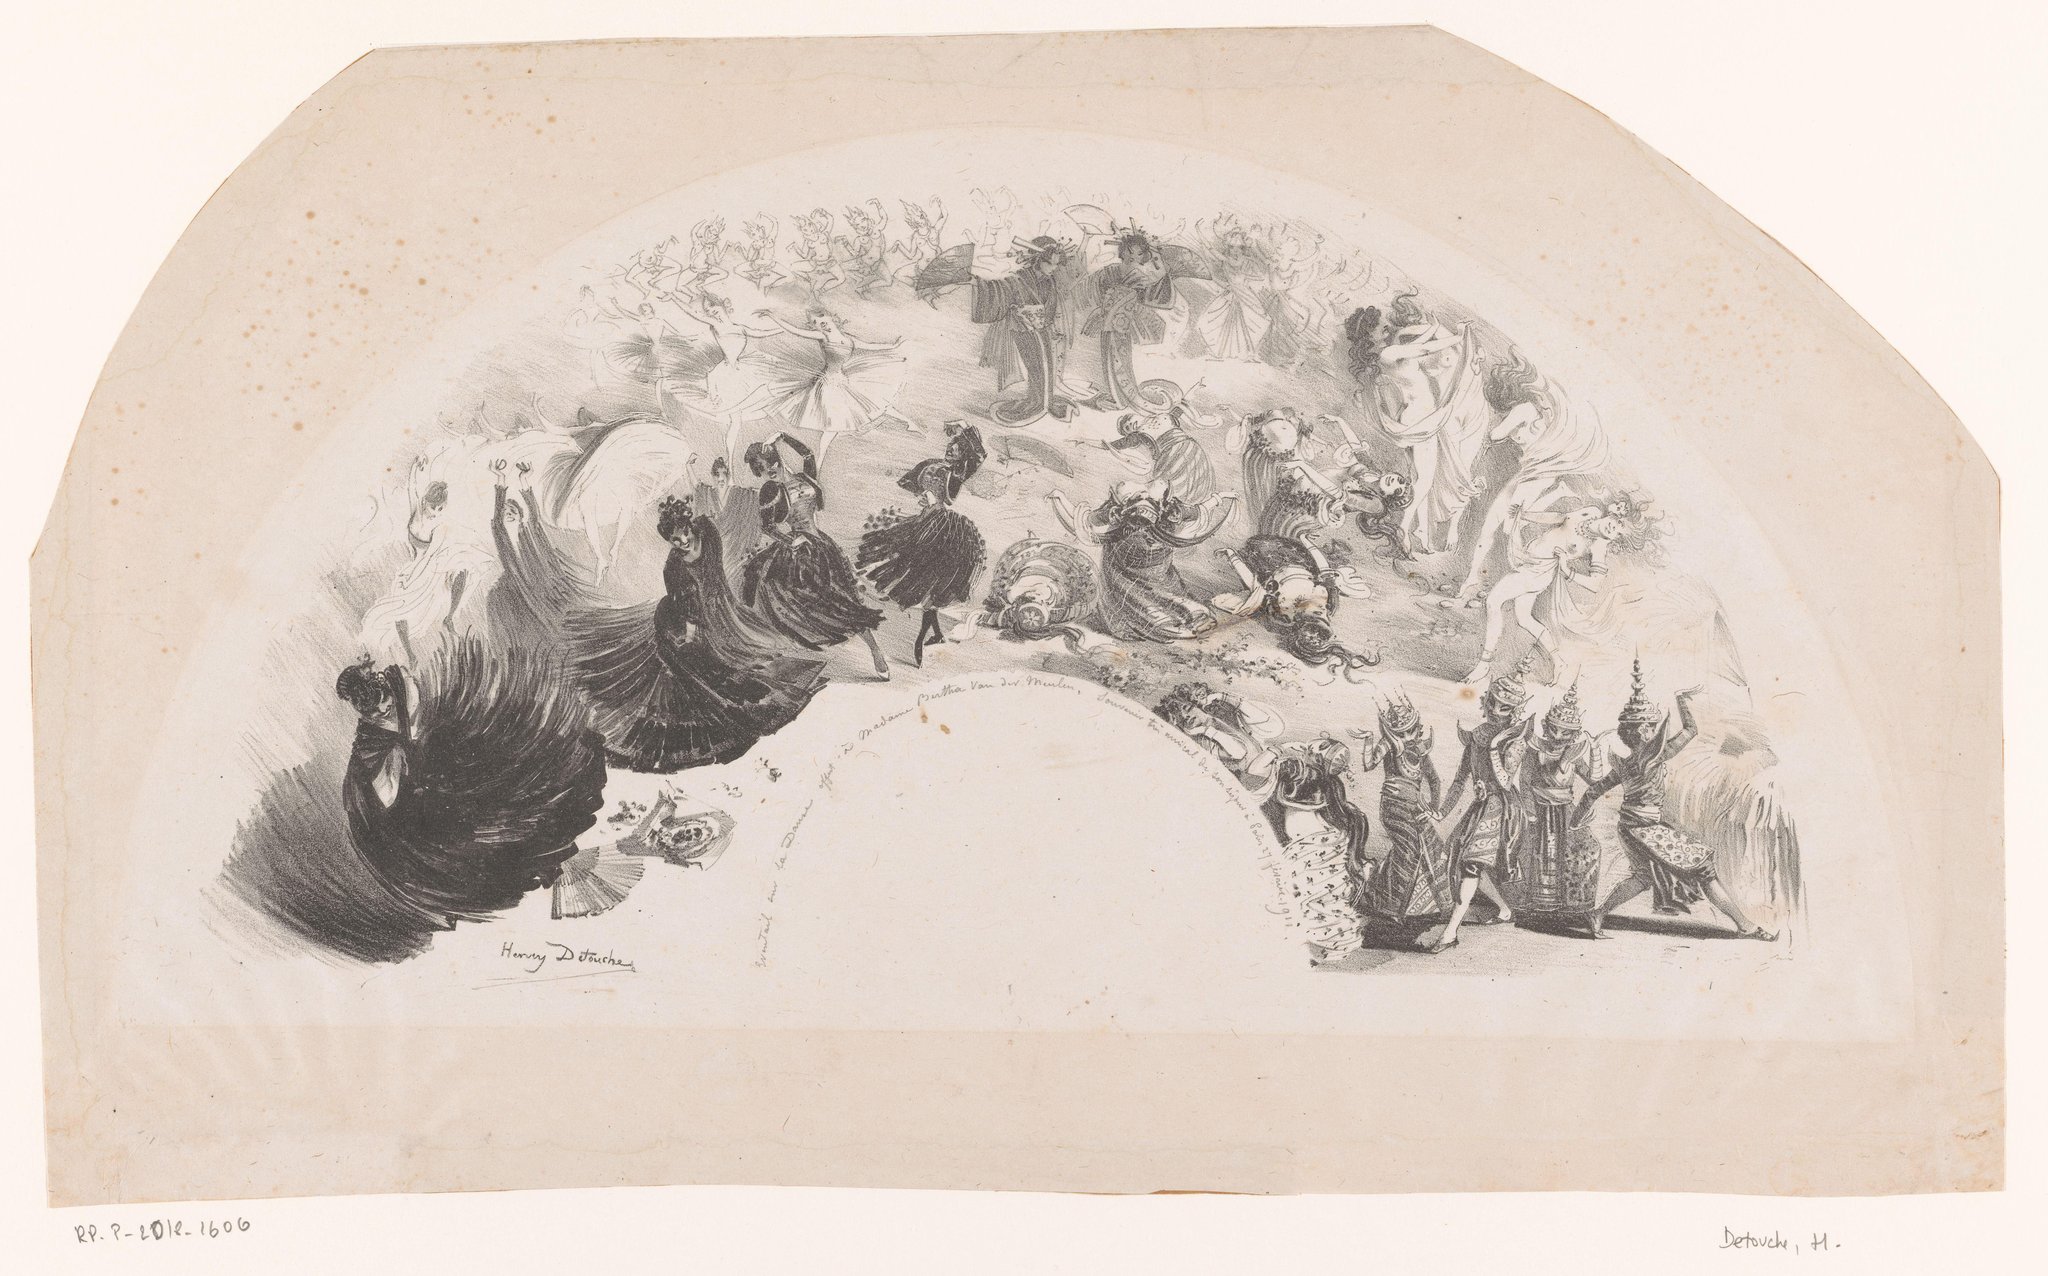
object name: print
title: Waaiervormige prent met danseressen in verschillende kostuums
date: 1911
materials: paper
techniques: lithograph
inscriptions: dedication: ‘Eventail sur la Danse offert à Madame Bertha Van der Meulen, Souvenir très amical de son séjour à Paris 27 février 1911.’